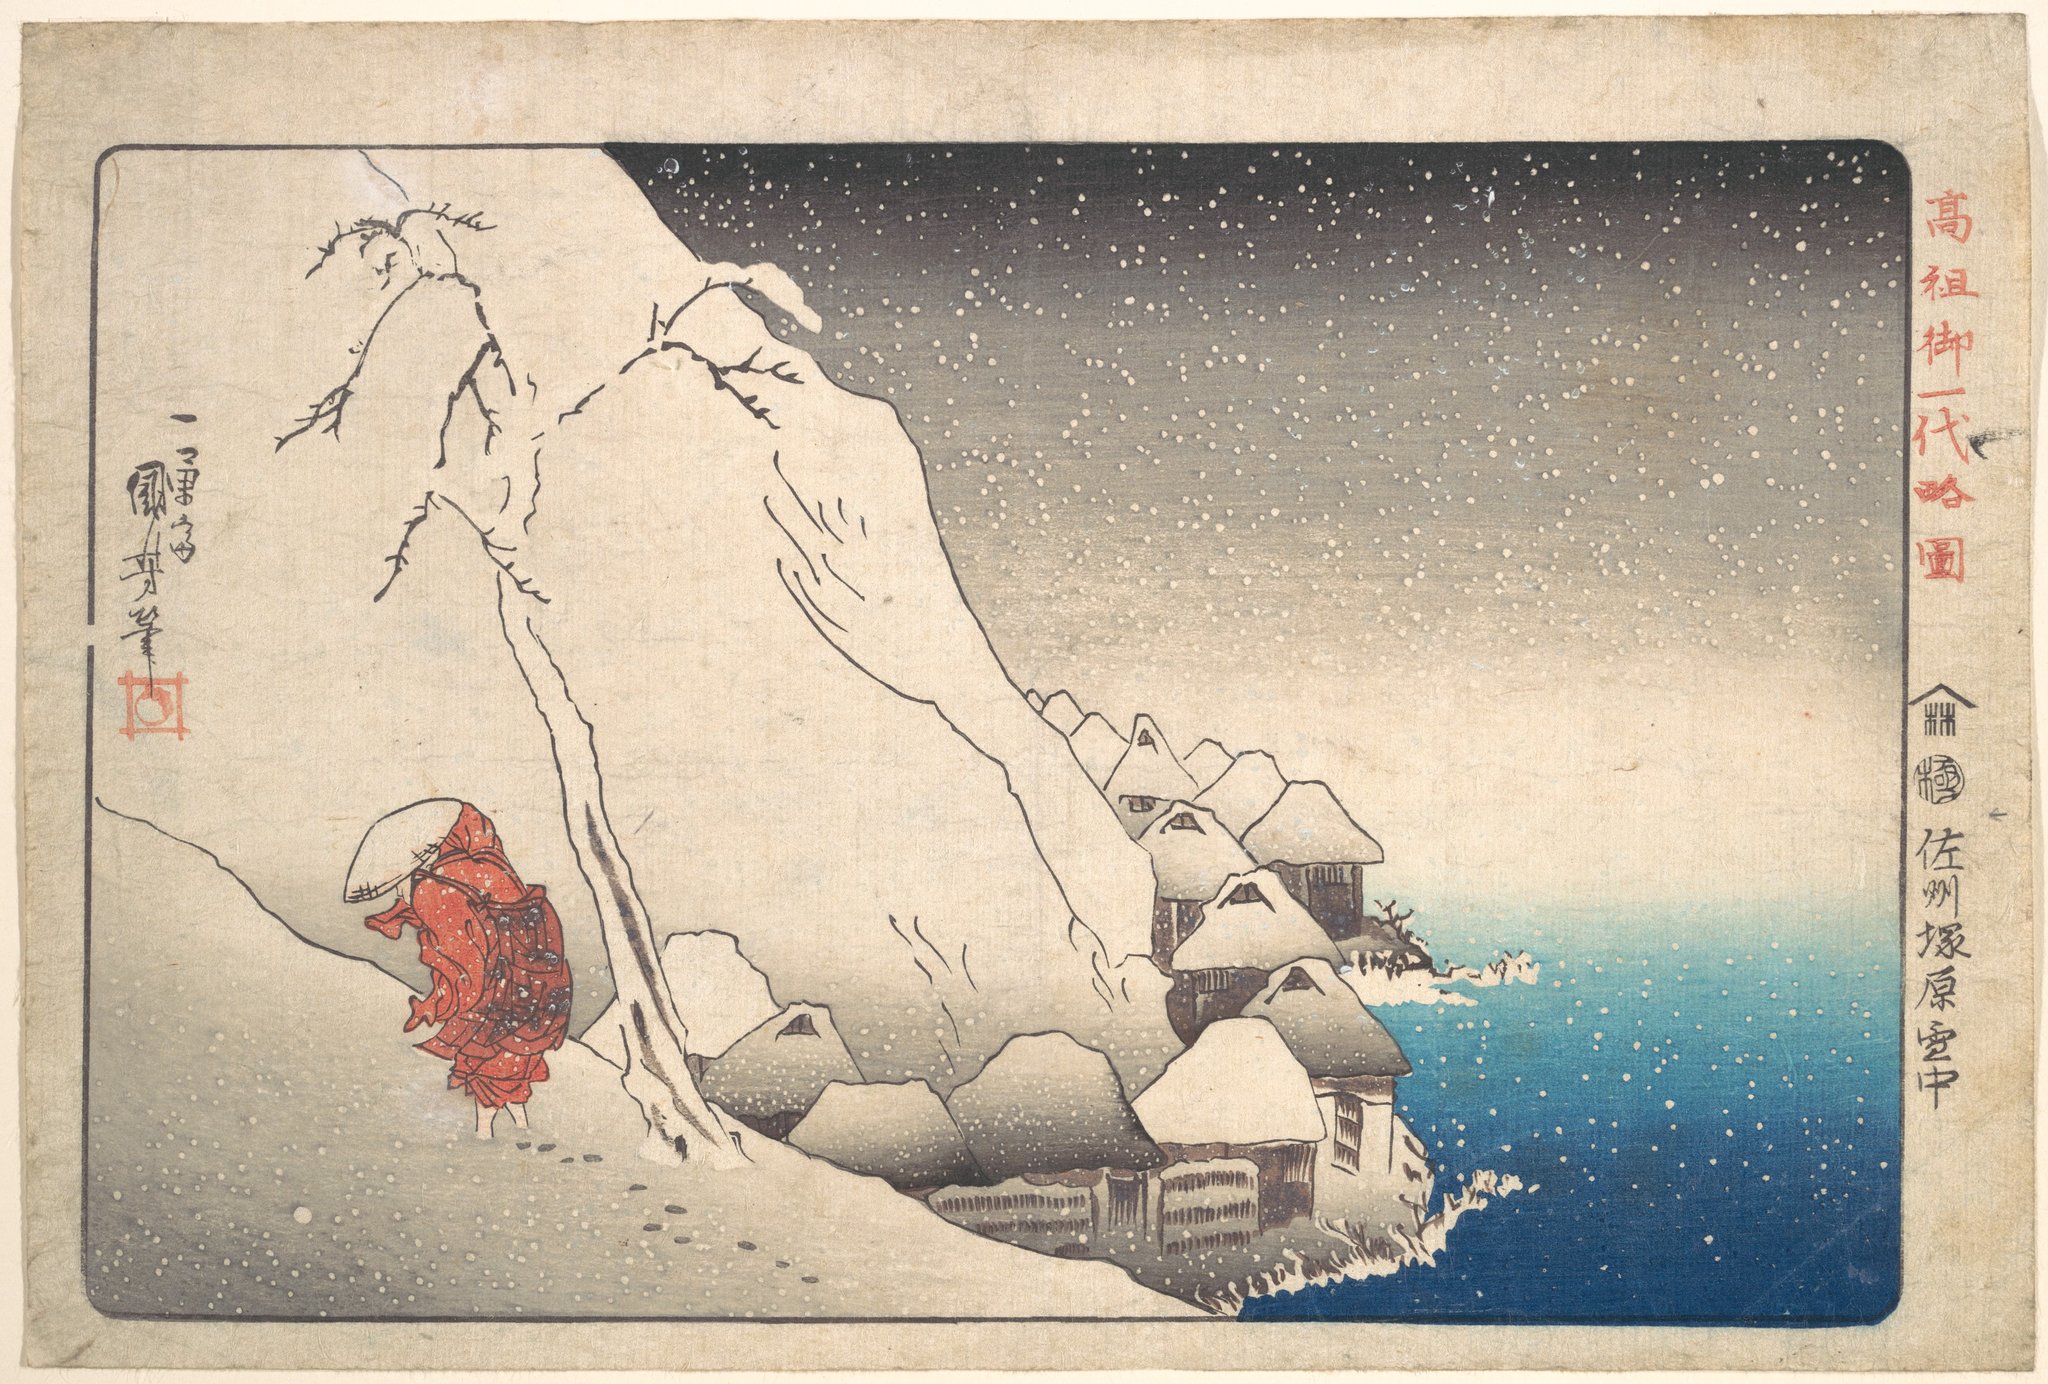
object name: print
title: Nichiren in Snow at Tsukahara, Sodo Province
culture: japanese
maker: utagawa kuniyoshi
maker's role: artist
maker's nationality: japanese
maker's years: 1797-1861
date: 1840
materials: ink, paper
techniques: woodblock print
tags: human figures,houses,mountains,snow